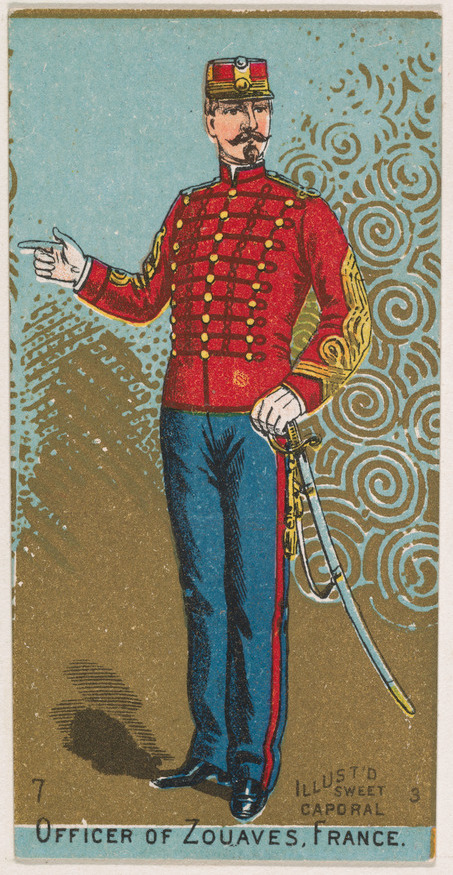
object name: print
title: Officer of Zouaves, France, from the Military Series (N224) issued by Kinney Tobacco Company to promote Sweet Caporal Cigarettes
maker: kinney brothers tobacco company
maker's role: publisher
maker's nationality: american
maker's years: 1869-2011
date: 1888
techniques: color lithograph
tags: military,men